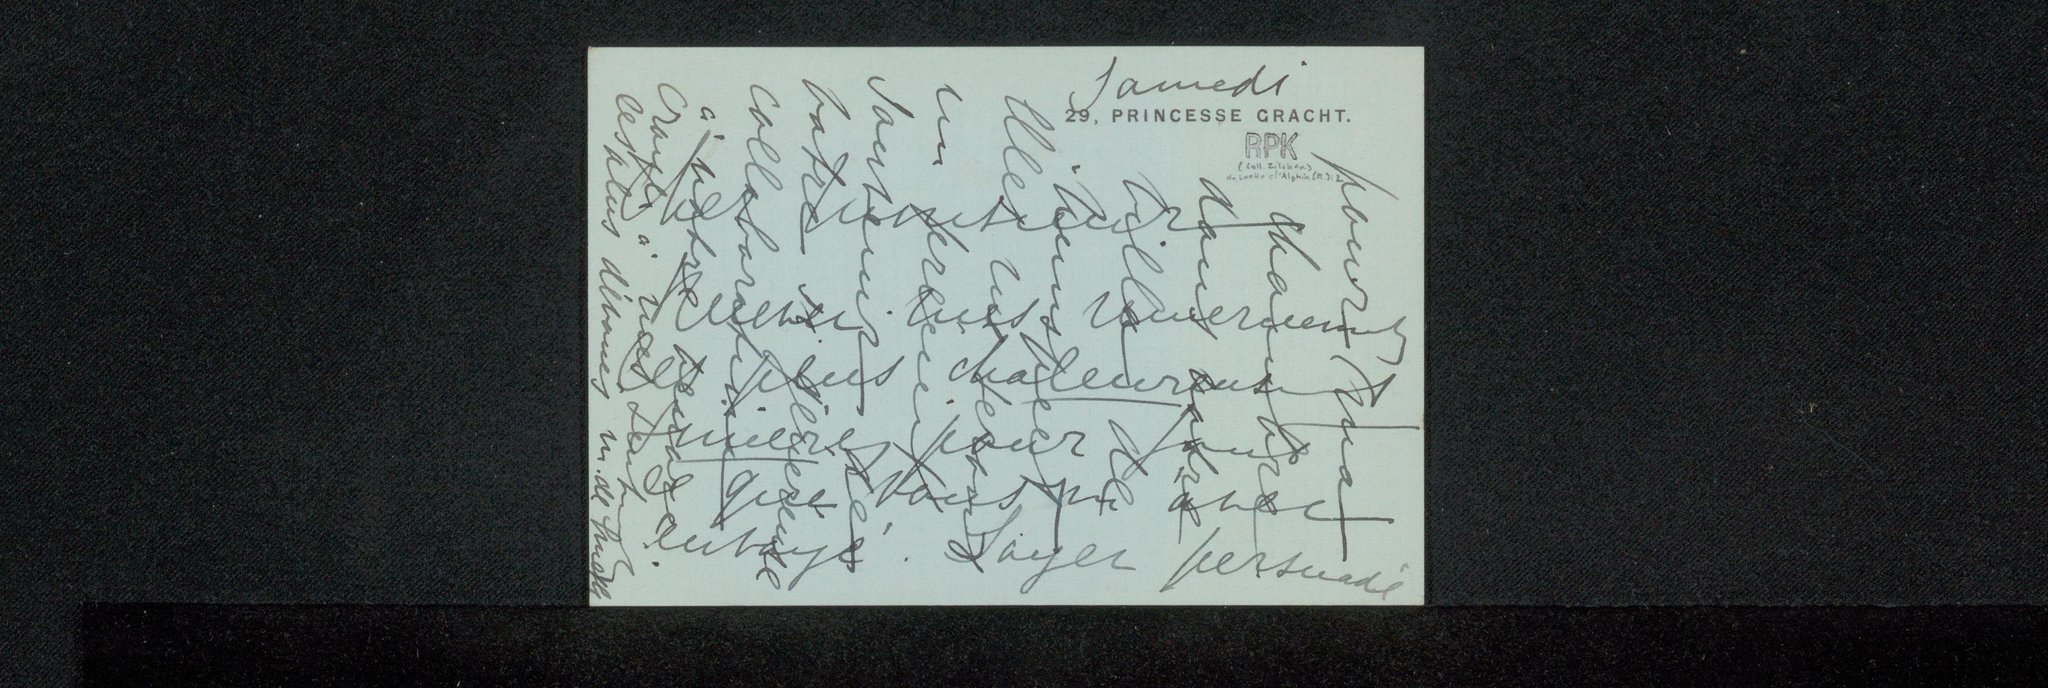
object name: letter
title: Brief aan Philip Zilcken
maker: m. de luette dalphin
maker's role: schrijver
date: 1867-1930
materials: cardboard, ink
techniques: pen, printing, writing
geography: the hague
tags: the hague, painter, draughtsman, philip zilcken, the graphic arts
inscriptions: collector's mark: ‘RPK’